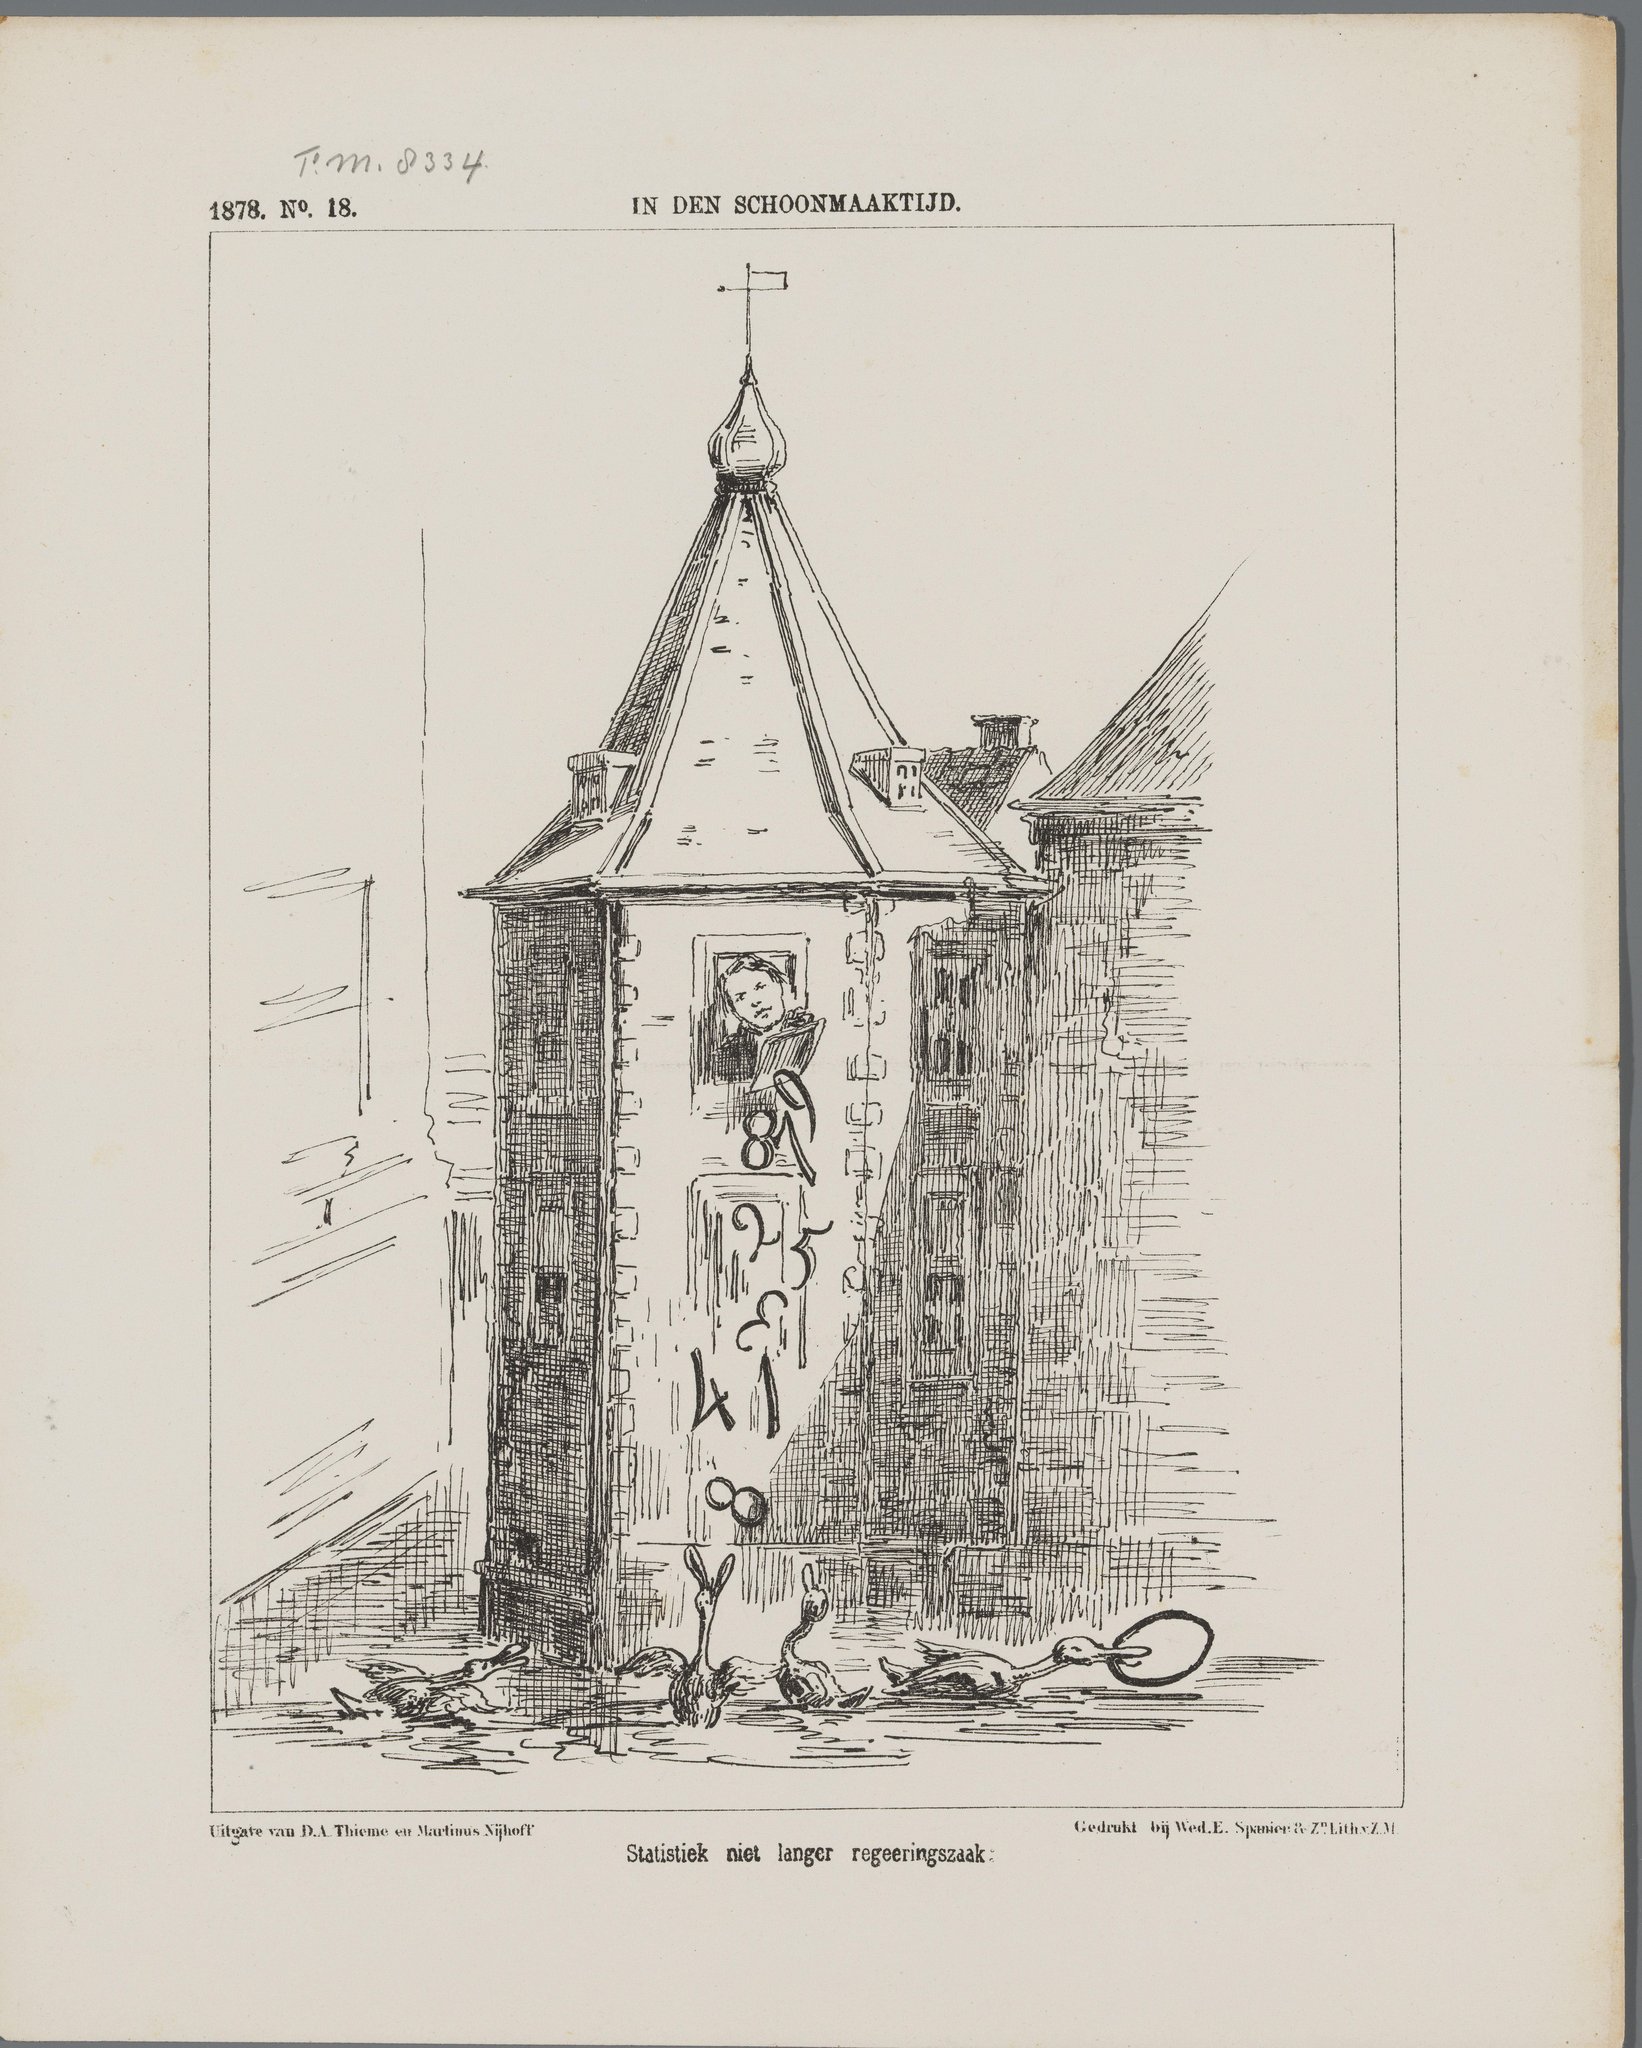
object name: cartoon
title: In den schoonmaaktijd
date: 1878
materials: paper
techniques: lithograph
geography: netherlands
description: Spotprent. Plaat verschenen bij het weekblad De Nederlandsche Spectator, nr. 18, 1878.